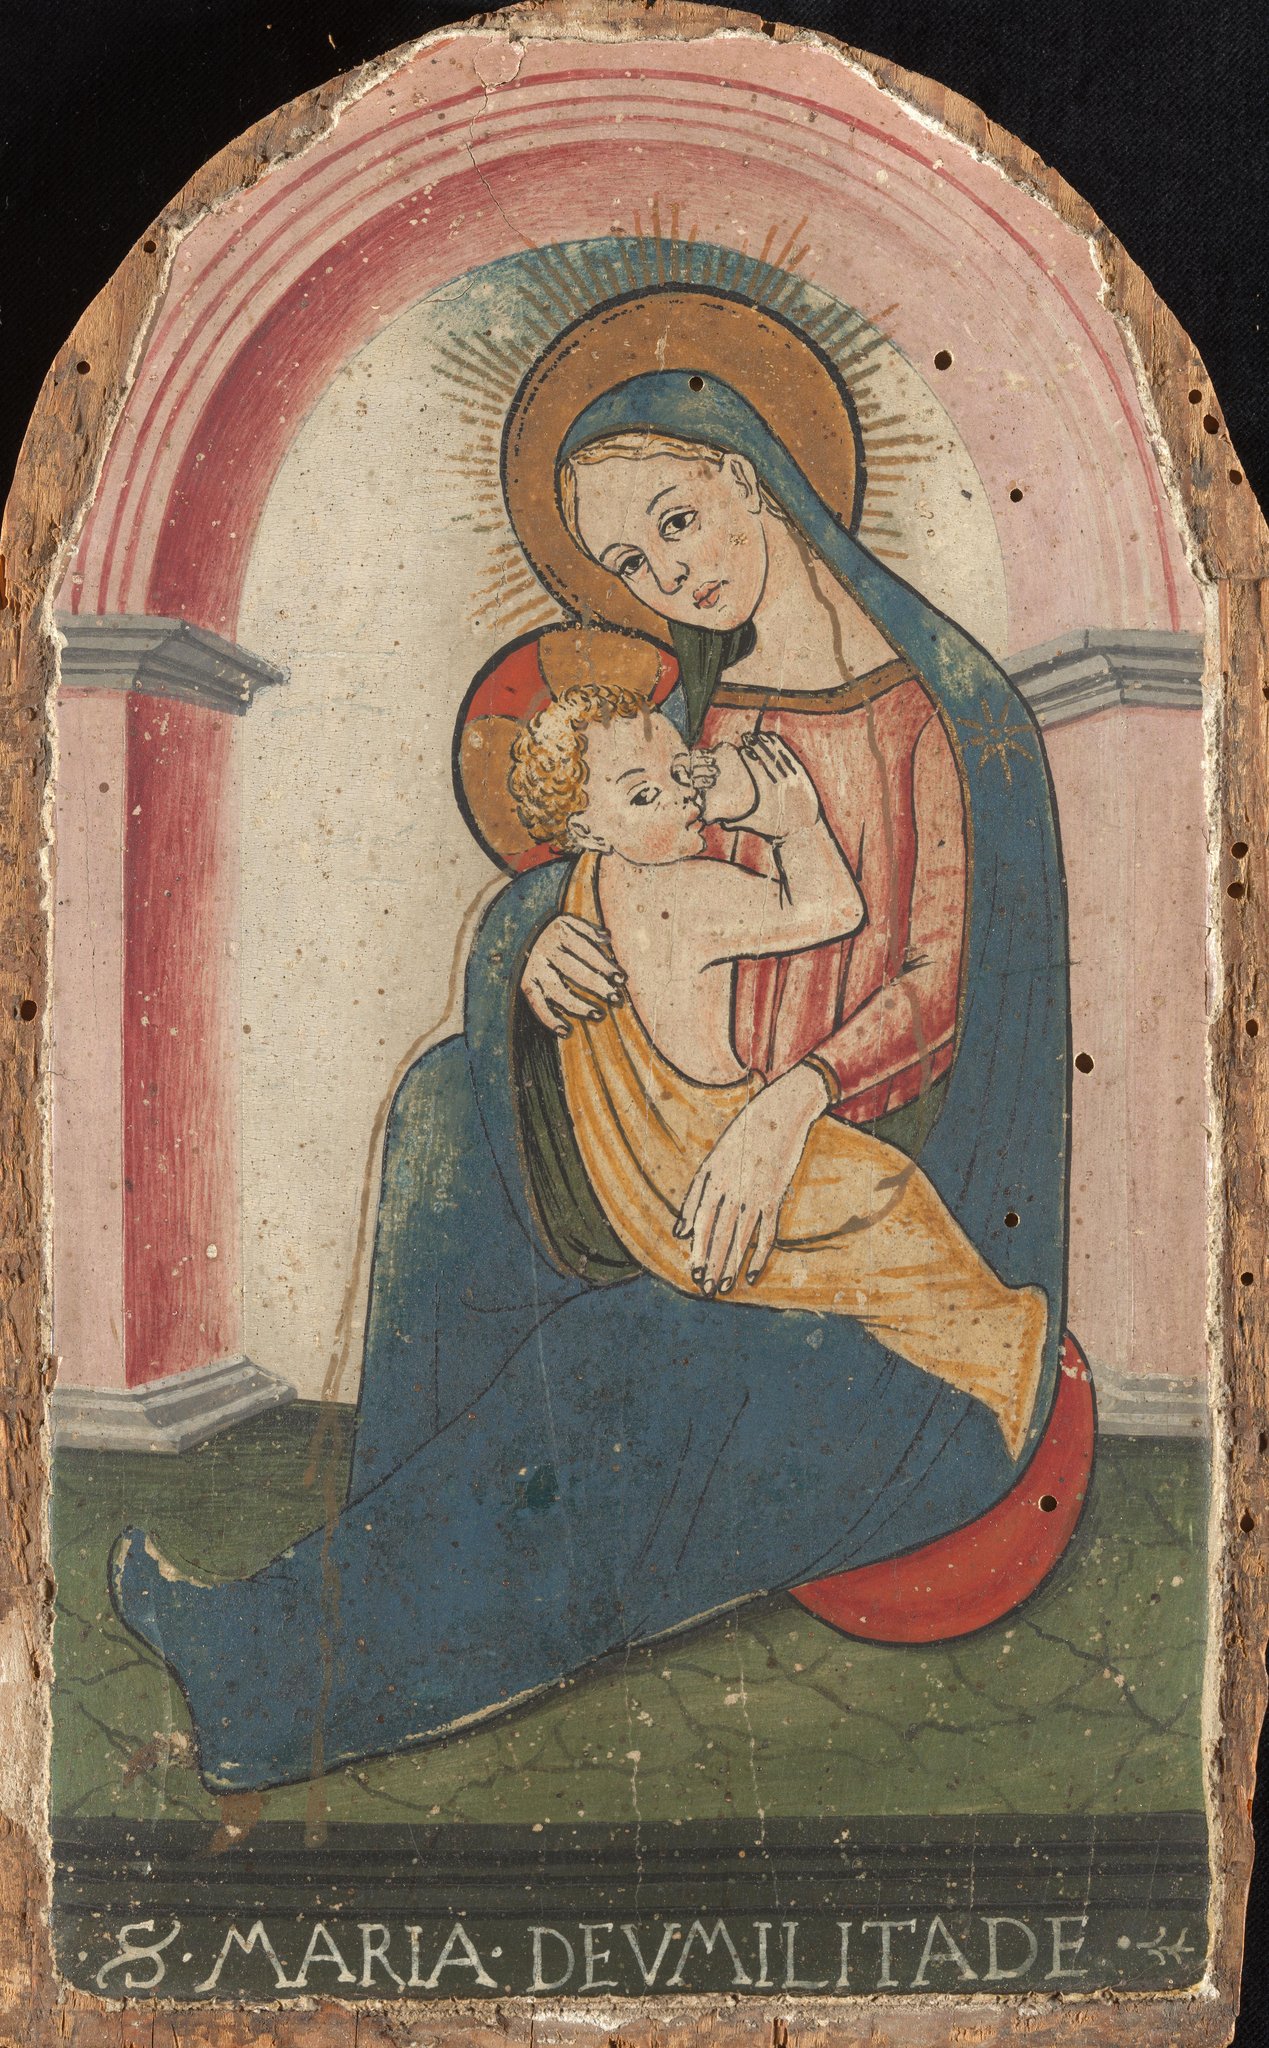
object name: painting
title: Madonna of Humility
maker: painter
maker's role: painter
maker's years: -1500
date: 1490-1500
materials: panel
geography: pistoia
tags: madonna: mary sitting on the ground, the christ-child in her lap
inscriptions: inscription: ‘S. Maria De Umilitade’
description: Madonna dell'humiltà. Madonna van de nederigheid. Maria zittend op de grond geeft het Christuskind de borst. Moderne vervalsing in de stijl van de Florentijnse School 15e eeuw.